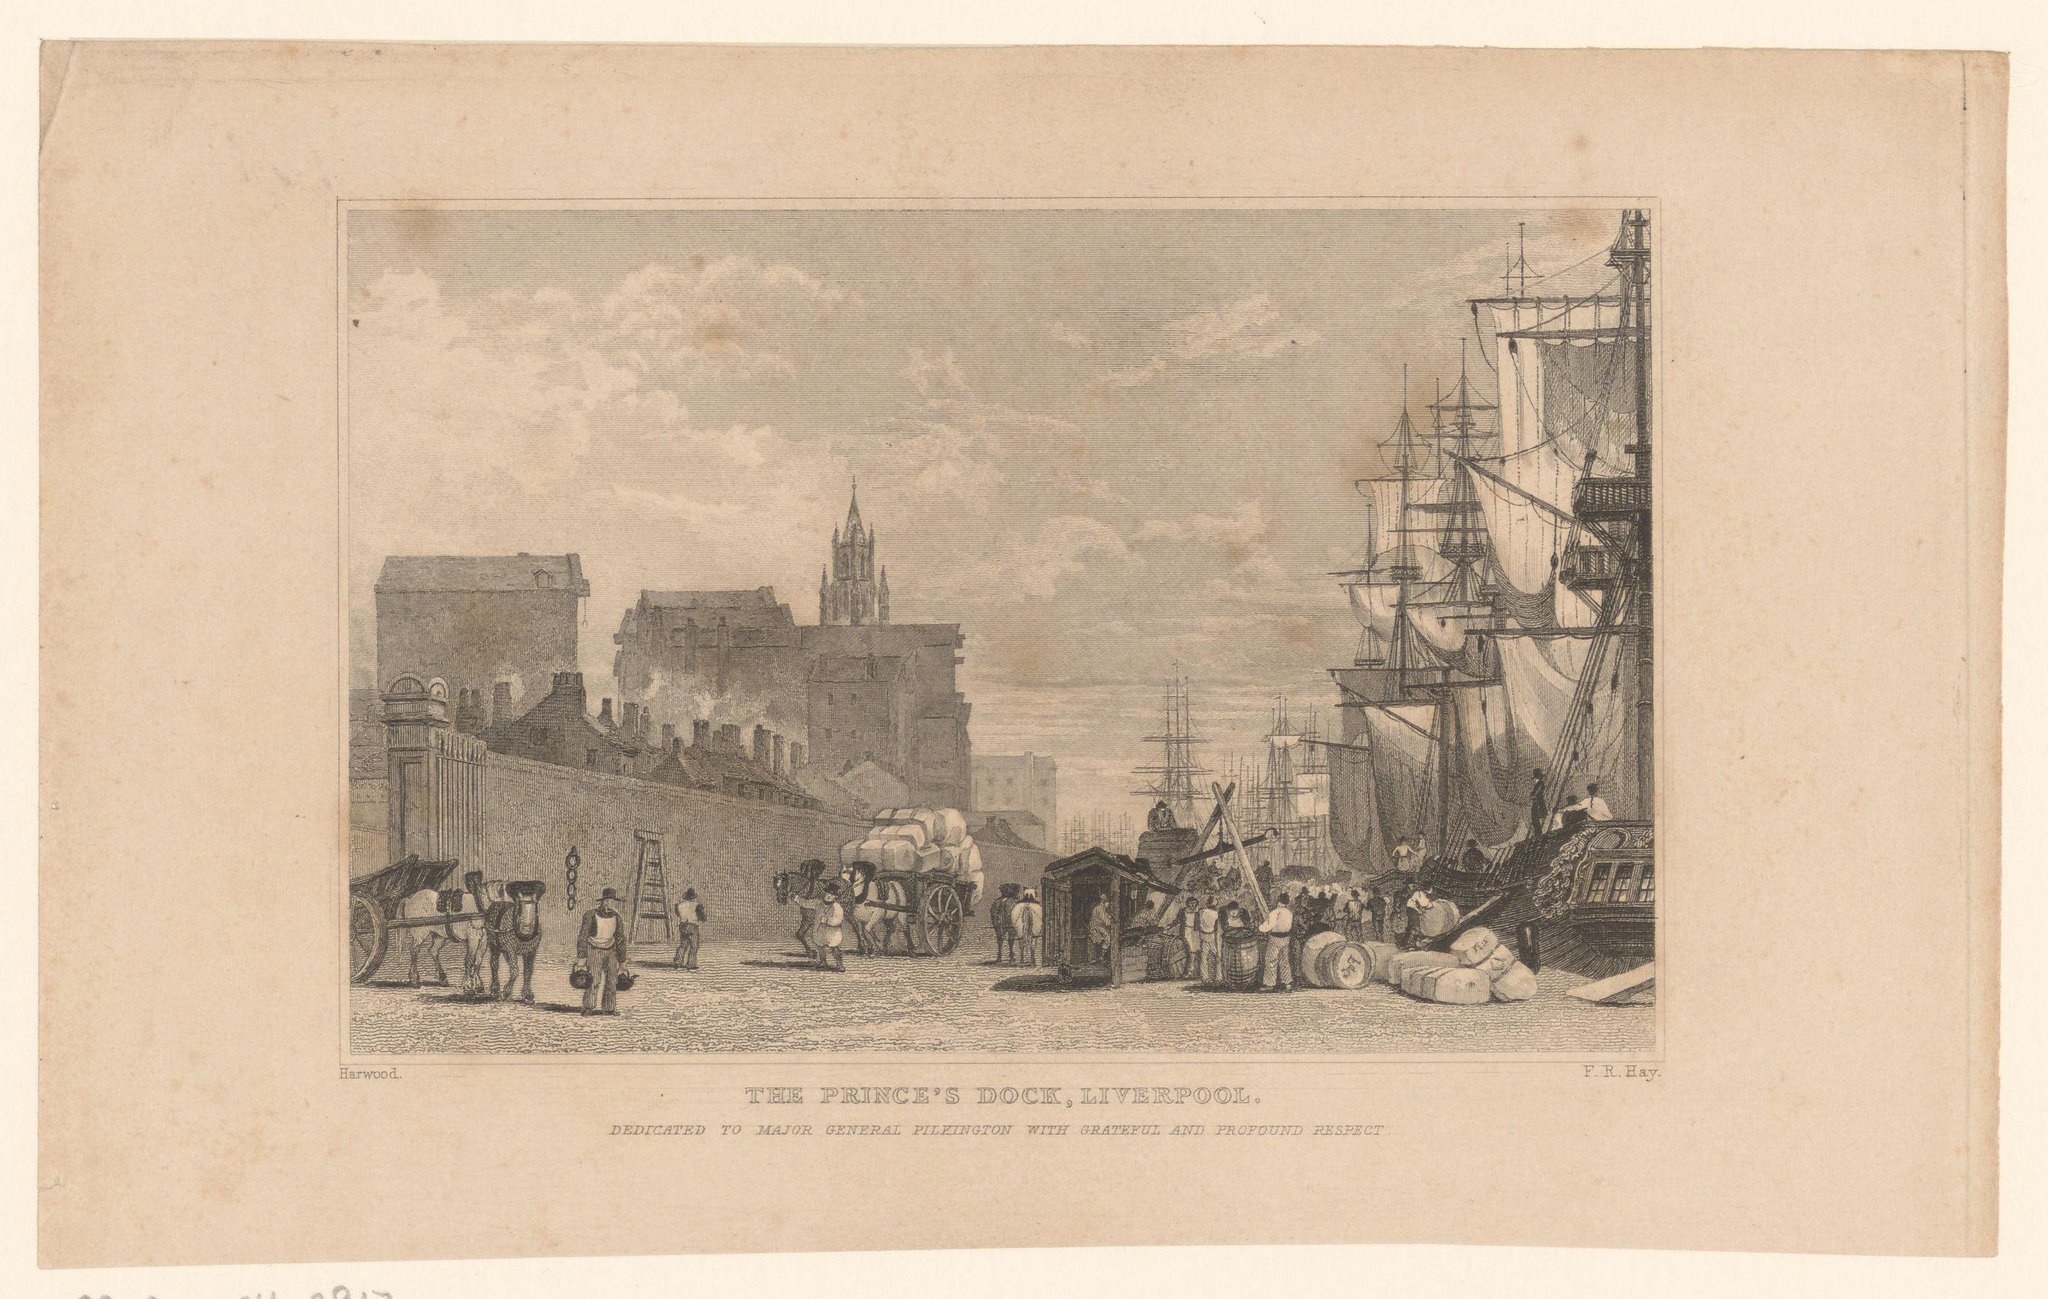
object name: print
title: The Prince's Dock, Liverpool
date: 1820-1860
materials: paper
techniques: etching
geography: great britain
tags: harbour, sailing-ship, sailing-boat, liverpool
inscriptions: collector's mark: Lugt 2228